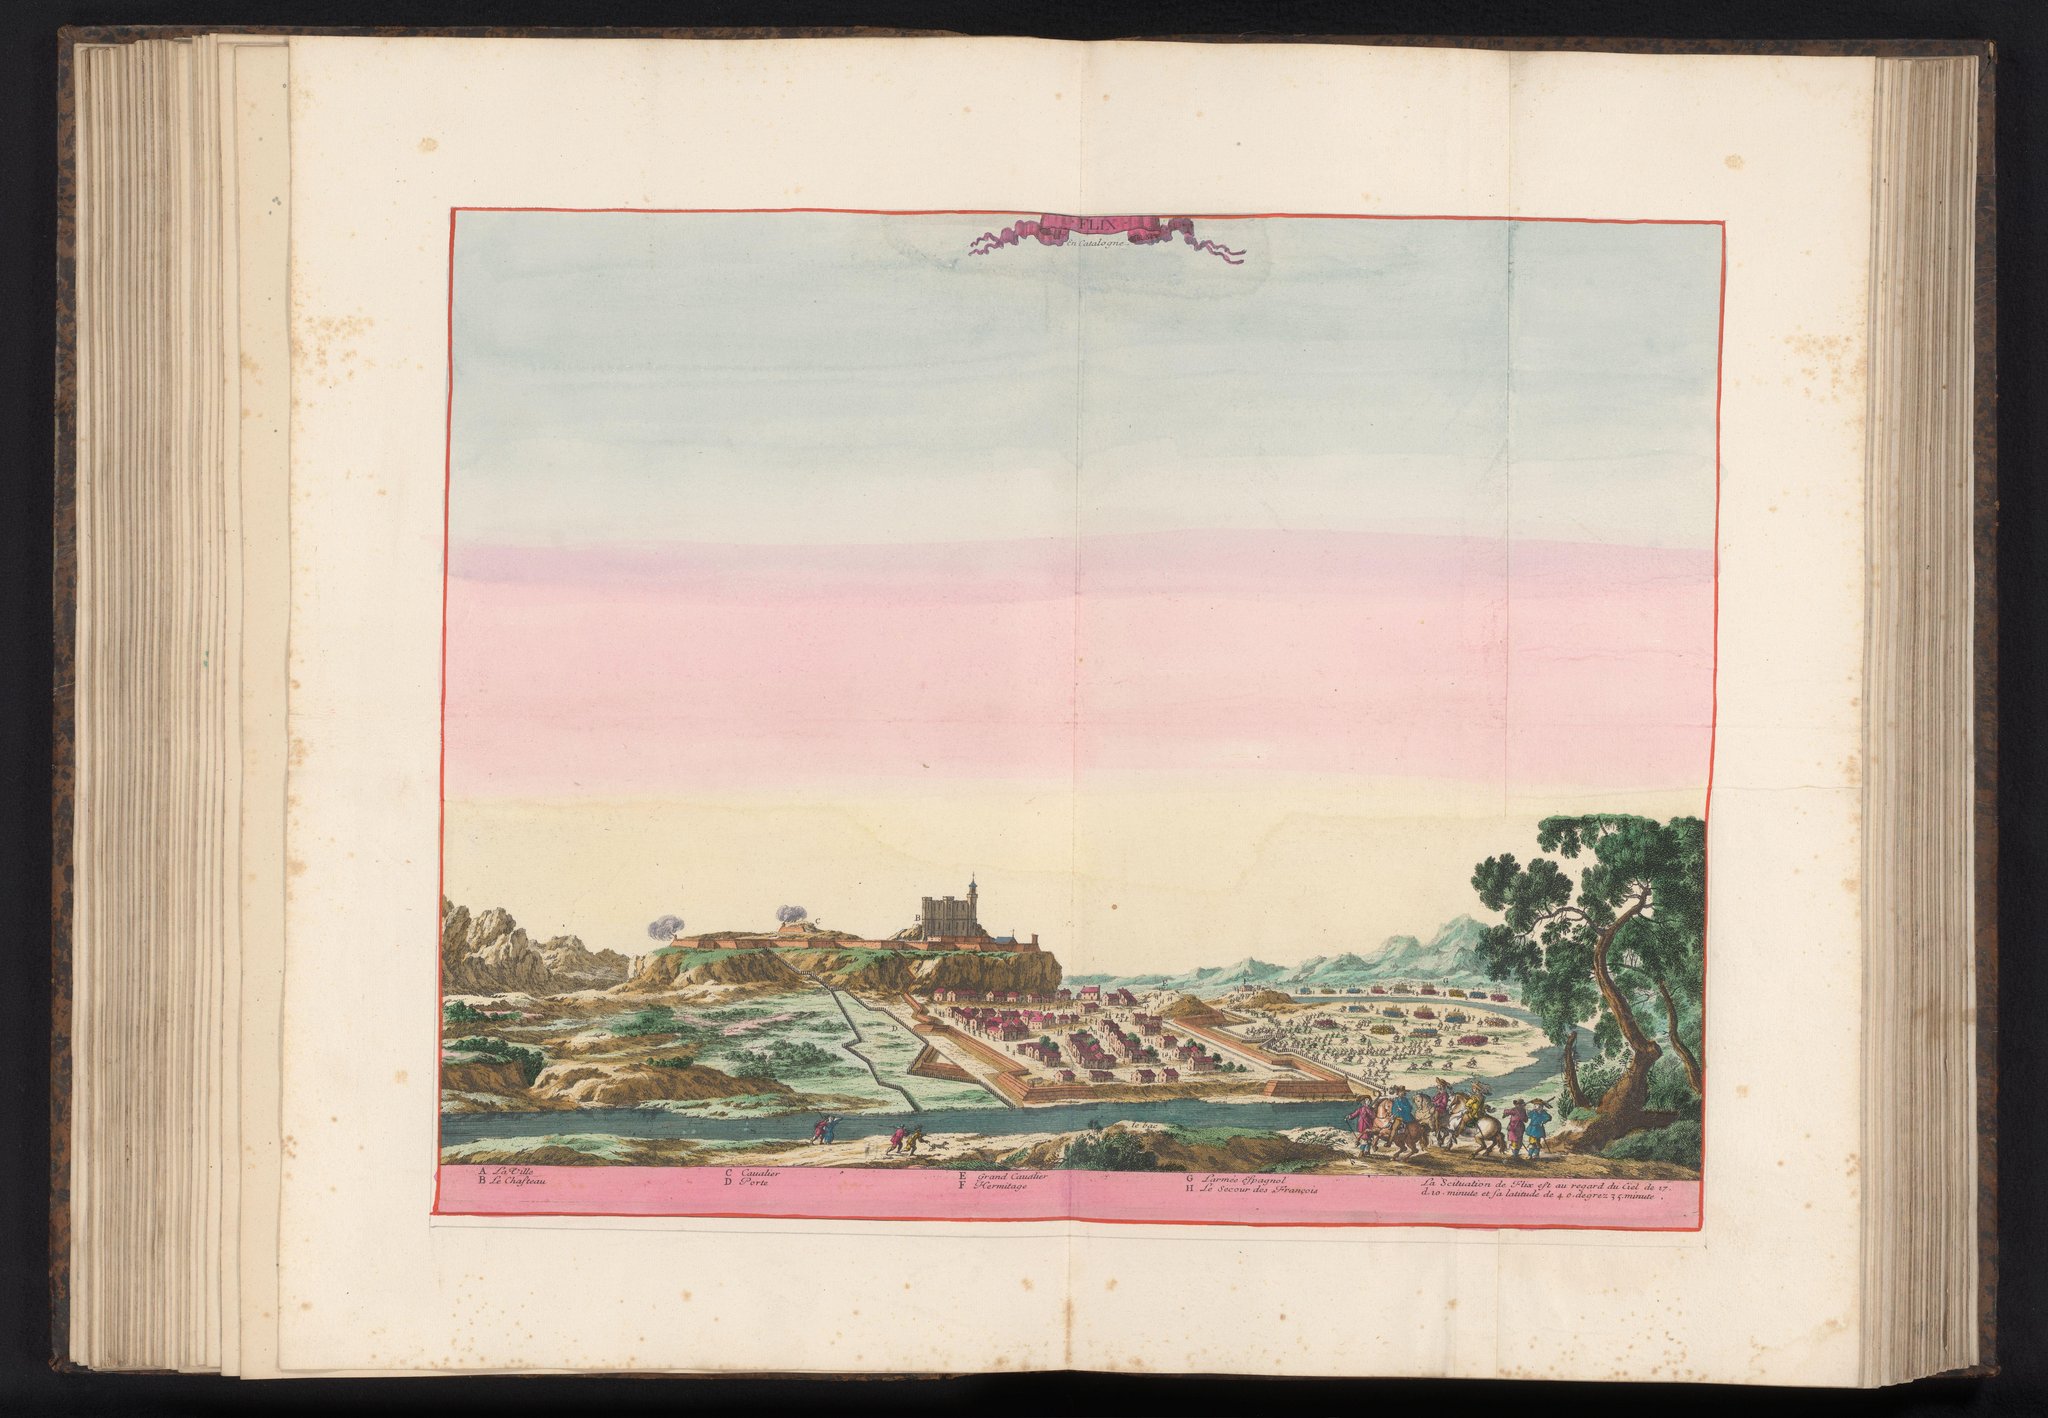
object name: print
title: Flix en Catalogne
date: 1659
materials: paper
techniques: etching, hand coloring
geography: the hague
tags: city-view, and landscape with man-made constructions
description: De prent is langs de bovenrand van de heuvels afgescheurd. Het bovenste gedeelte met de lucht is hoger opgeplakt, zodat de lucht hoger is geworden en het formaat van de voorstelling past bij de andere groot formaatvoorstellingen in het album.